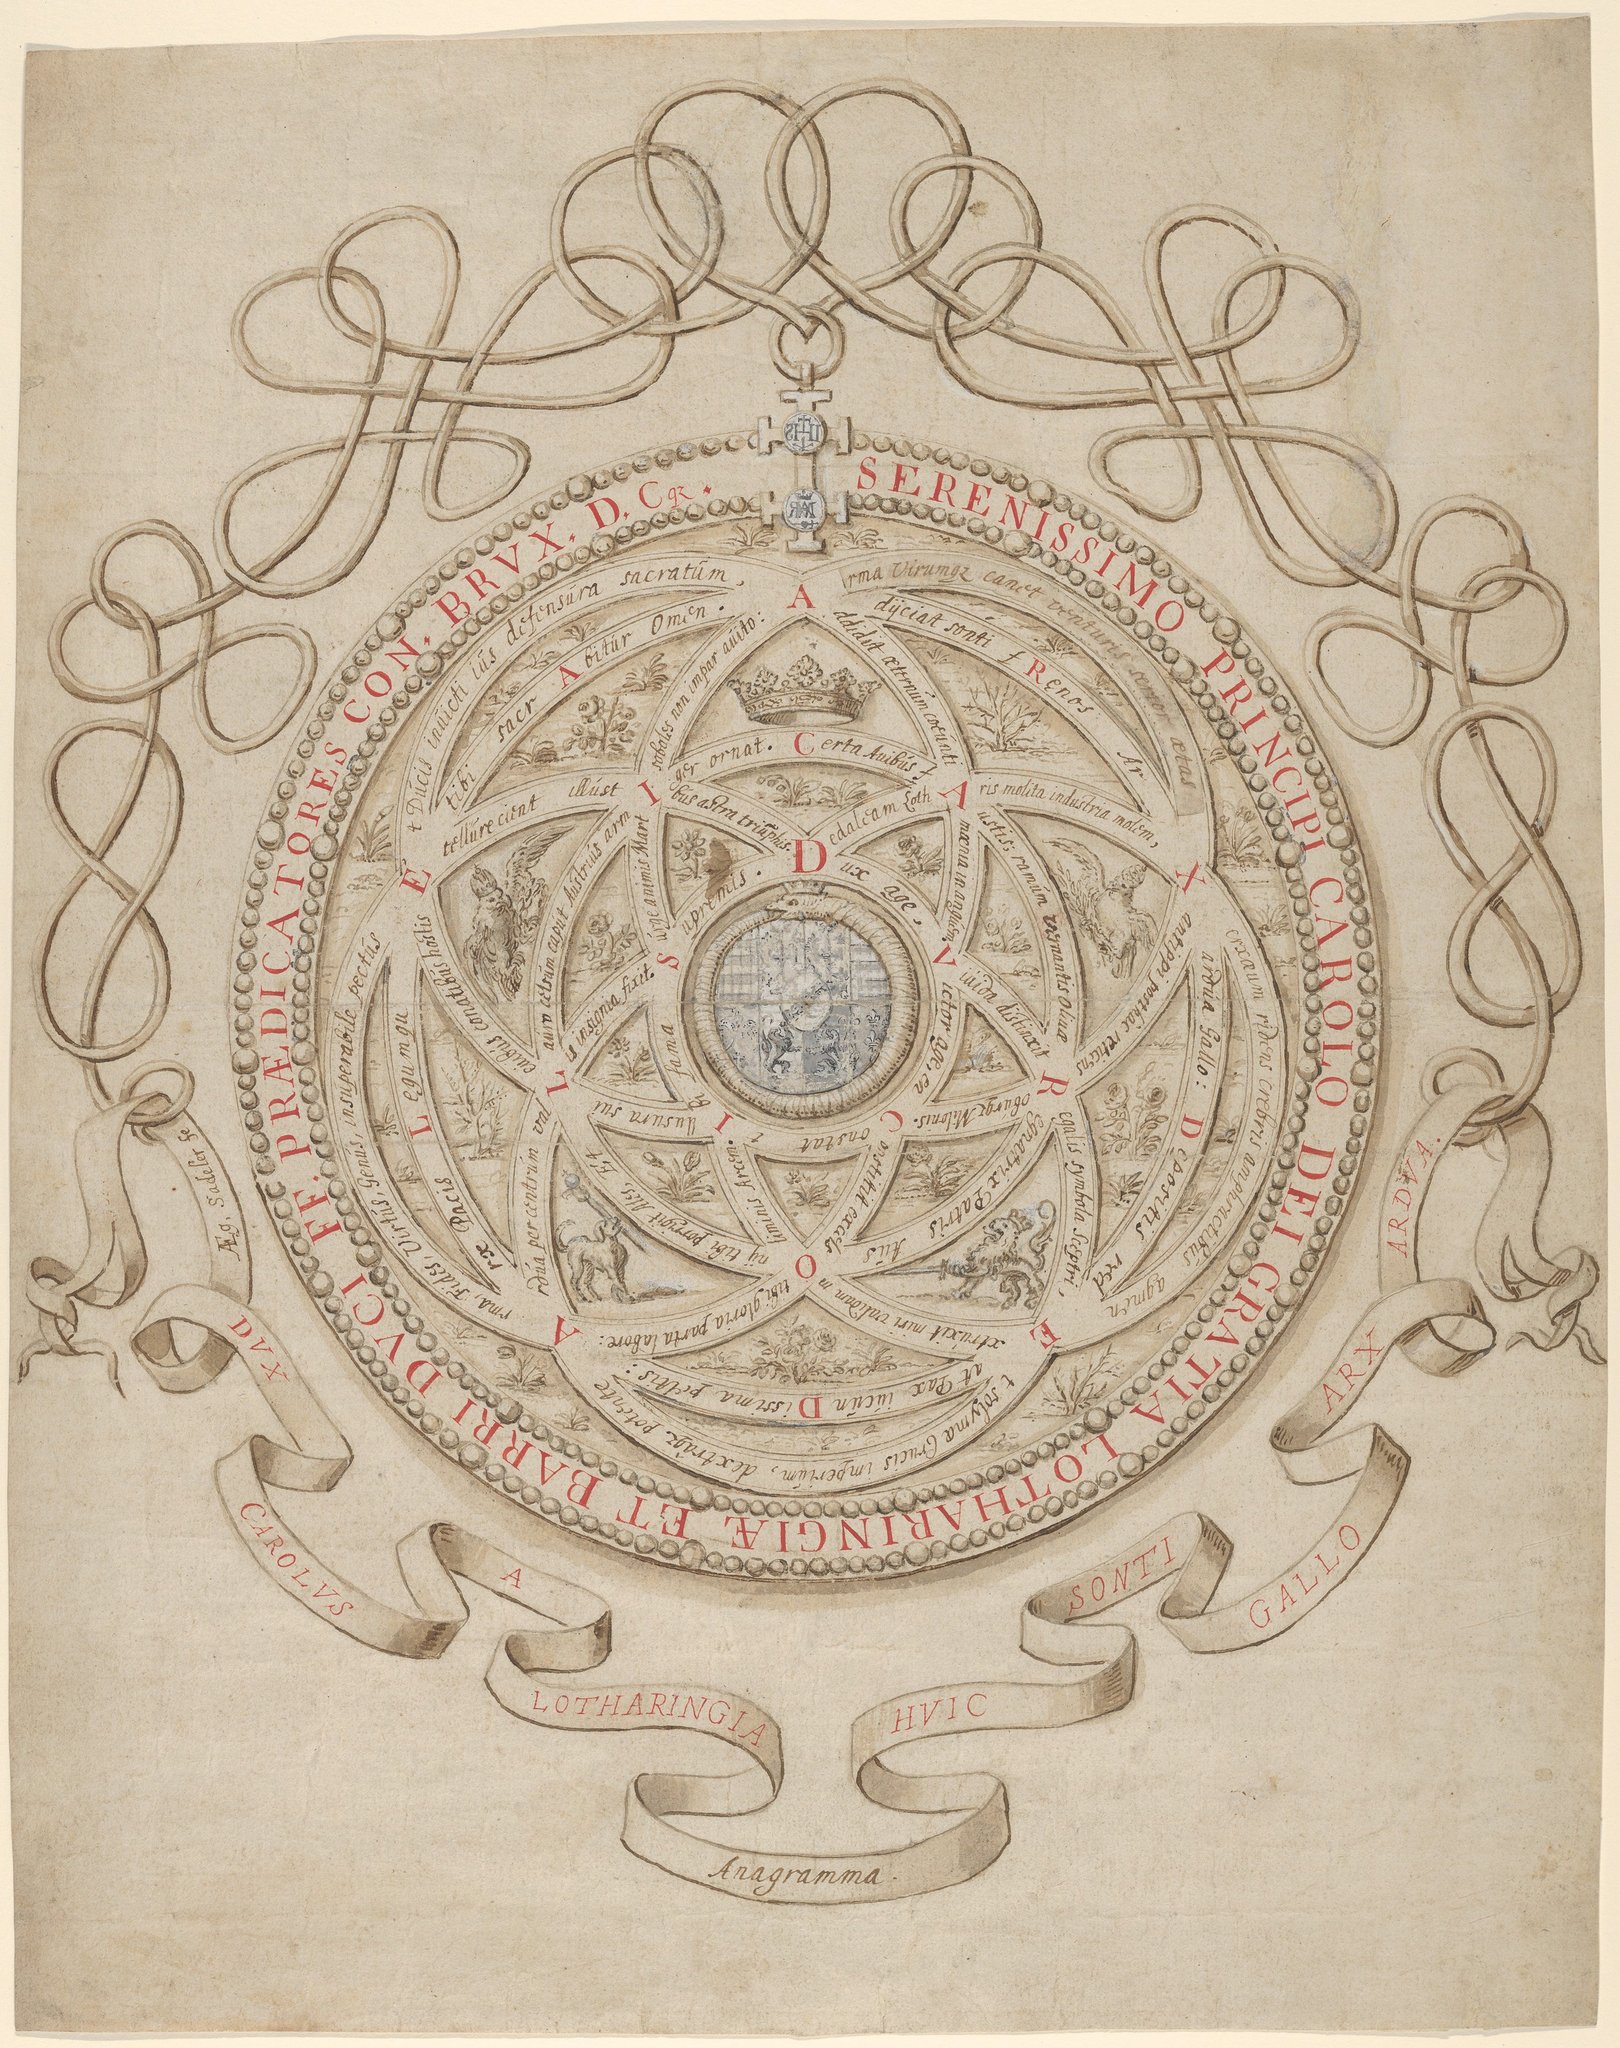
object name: drawing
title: Anagram in Honor of Charles III, Duke of Lorraine and Bar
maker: aegidius sadeler (ii)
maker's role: artist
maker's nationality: flemish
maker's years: 1568-1629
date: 1595-1605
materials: gouache, ink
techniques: incising, pen, wash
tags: eagles,dogs,lions,coat of arms,crowns